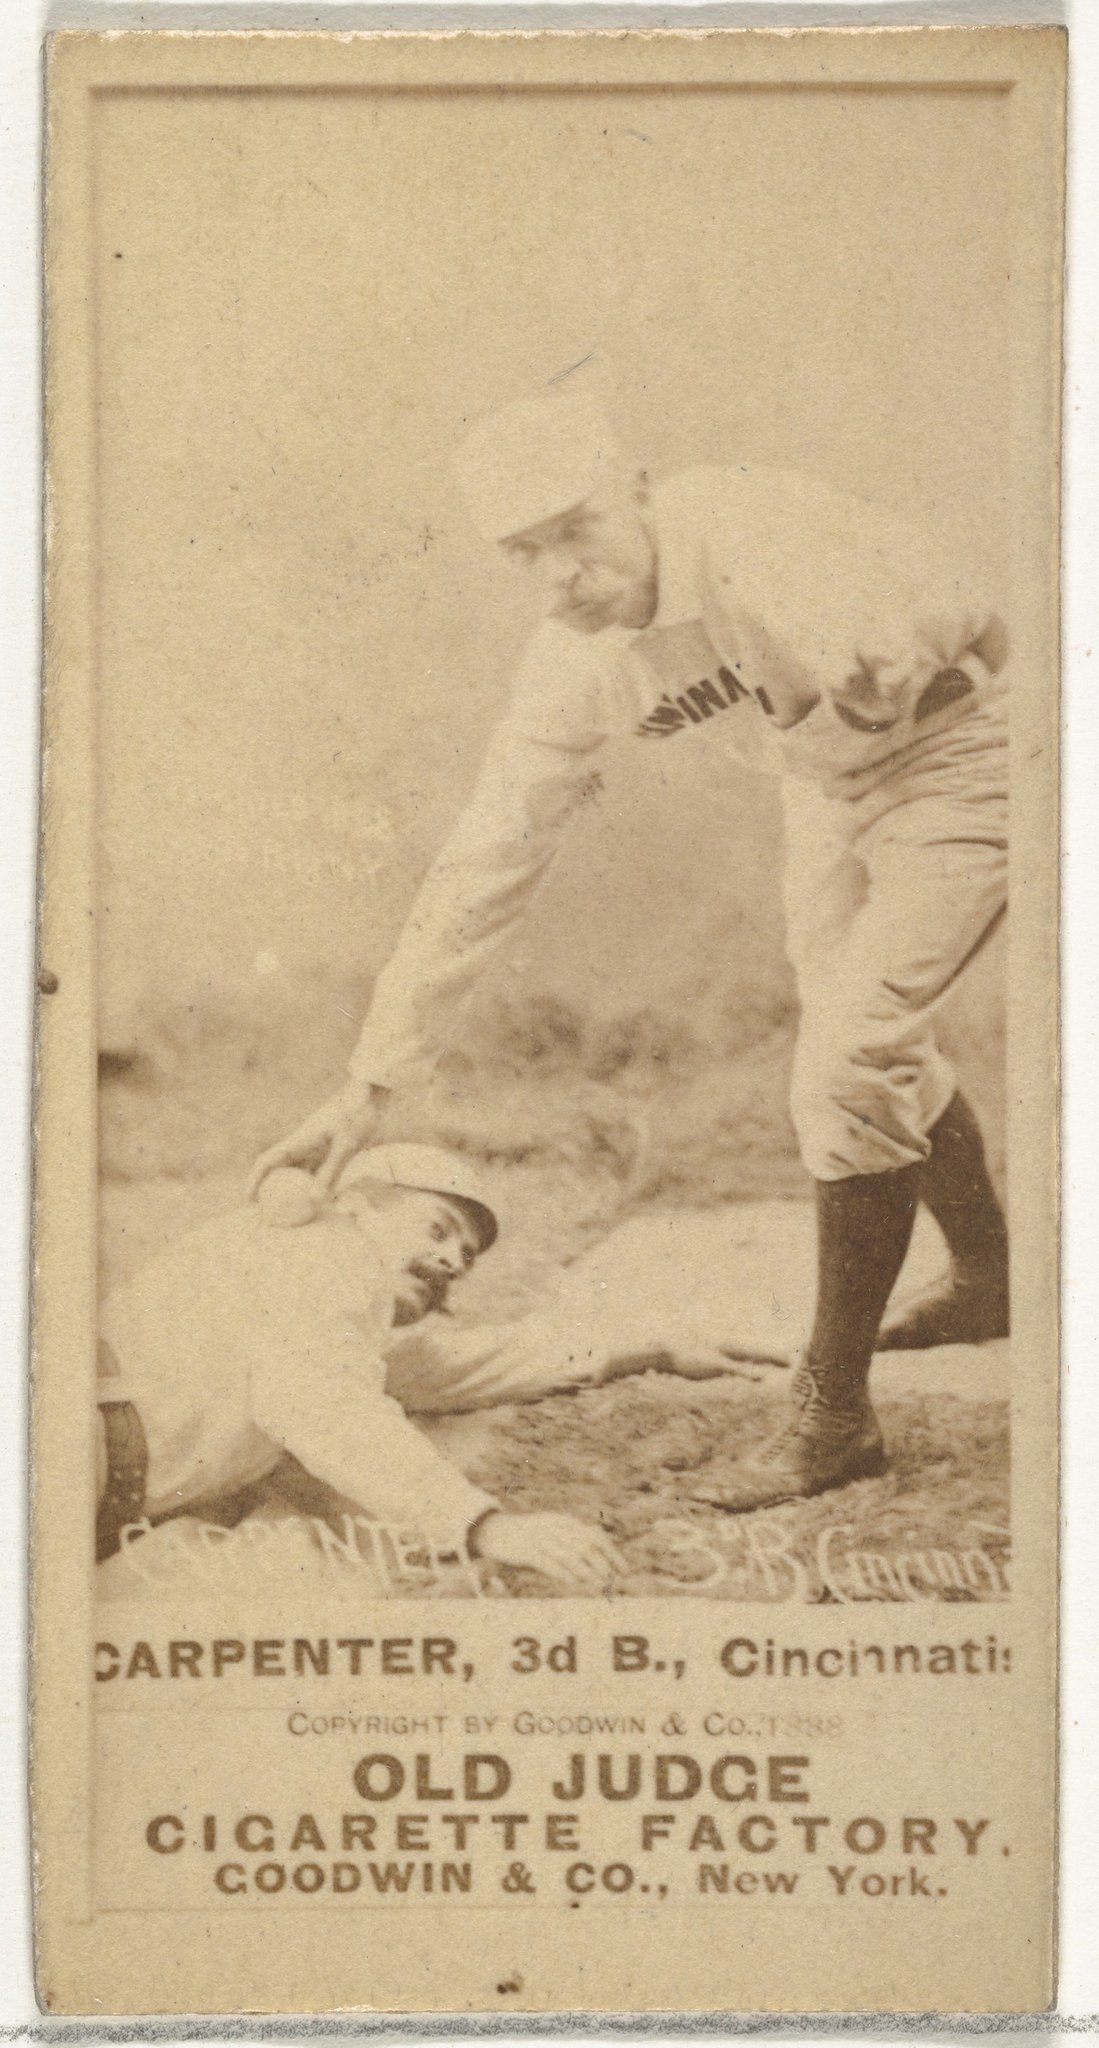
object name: baseball card, photograph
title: Warren William "Hick" Carpenter, 3rd Base, Cincinnati, from the Old Judge series (N172) for Old Judge Cigarettes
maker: goodwin & company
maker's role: publisher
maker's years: 1850-1950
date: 1888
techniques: albumen silver print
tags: men,portraits,baseball,athletes